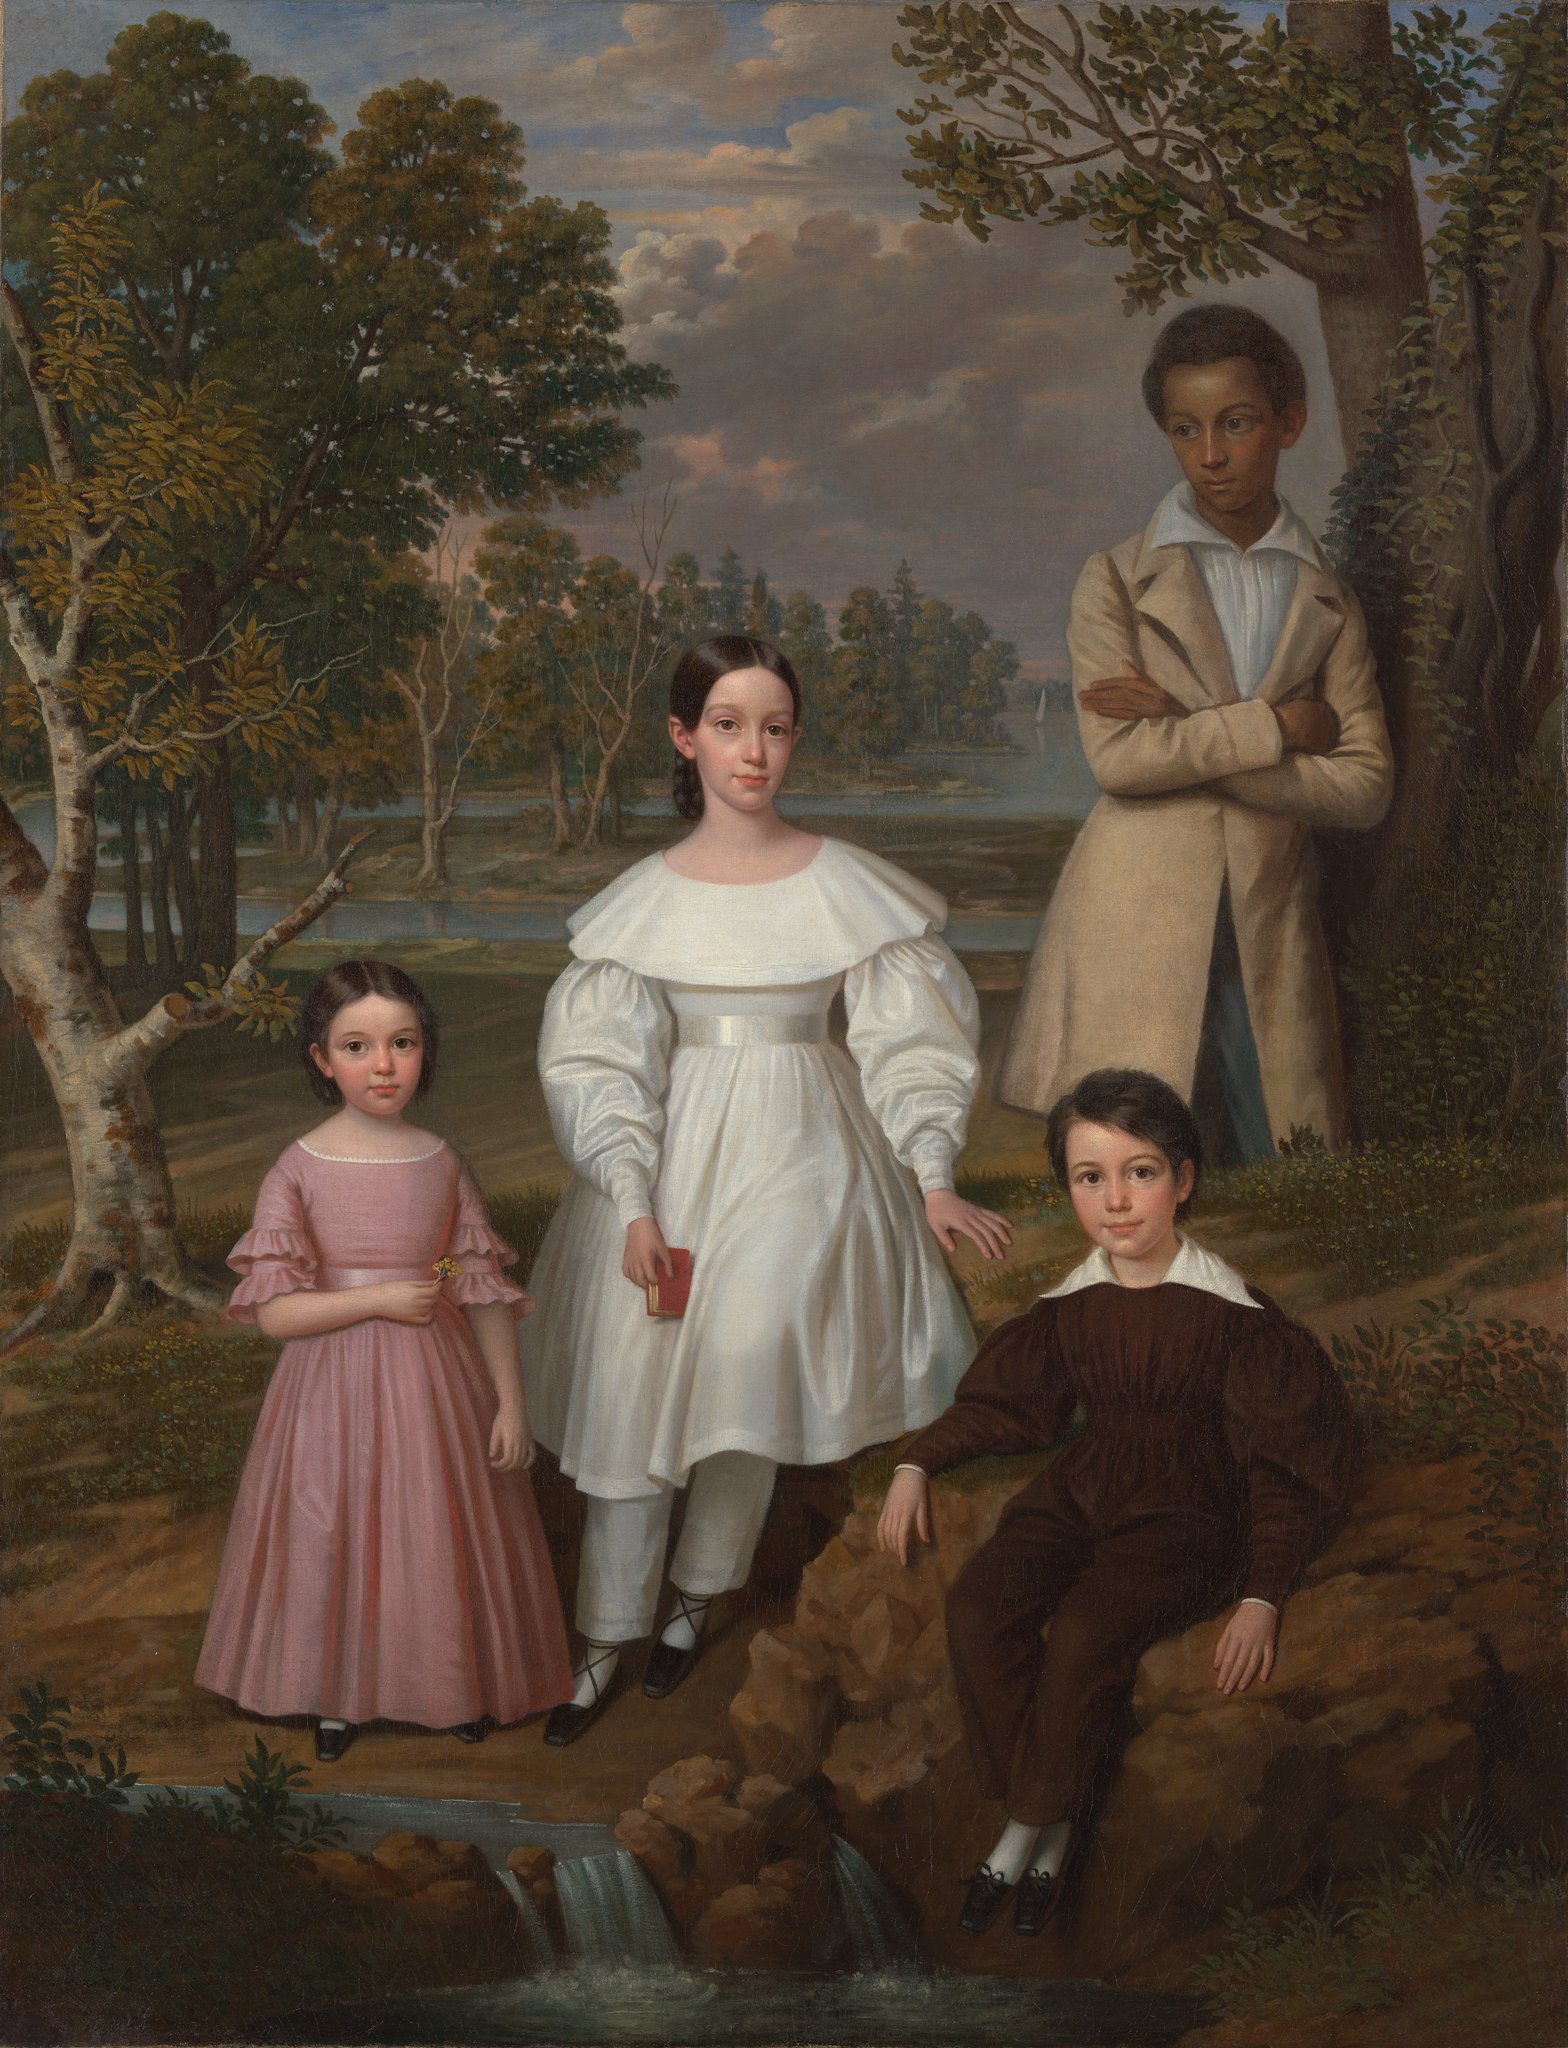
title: Bélizaire and the Frey Children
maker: jacques guillaume lucien amans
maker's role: artist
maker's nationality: franco-american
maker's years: 1801-1888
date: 1837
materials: canvas, oil